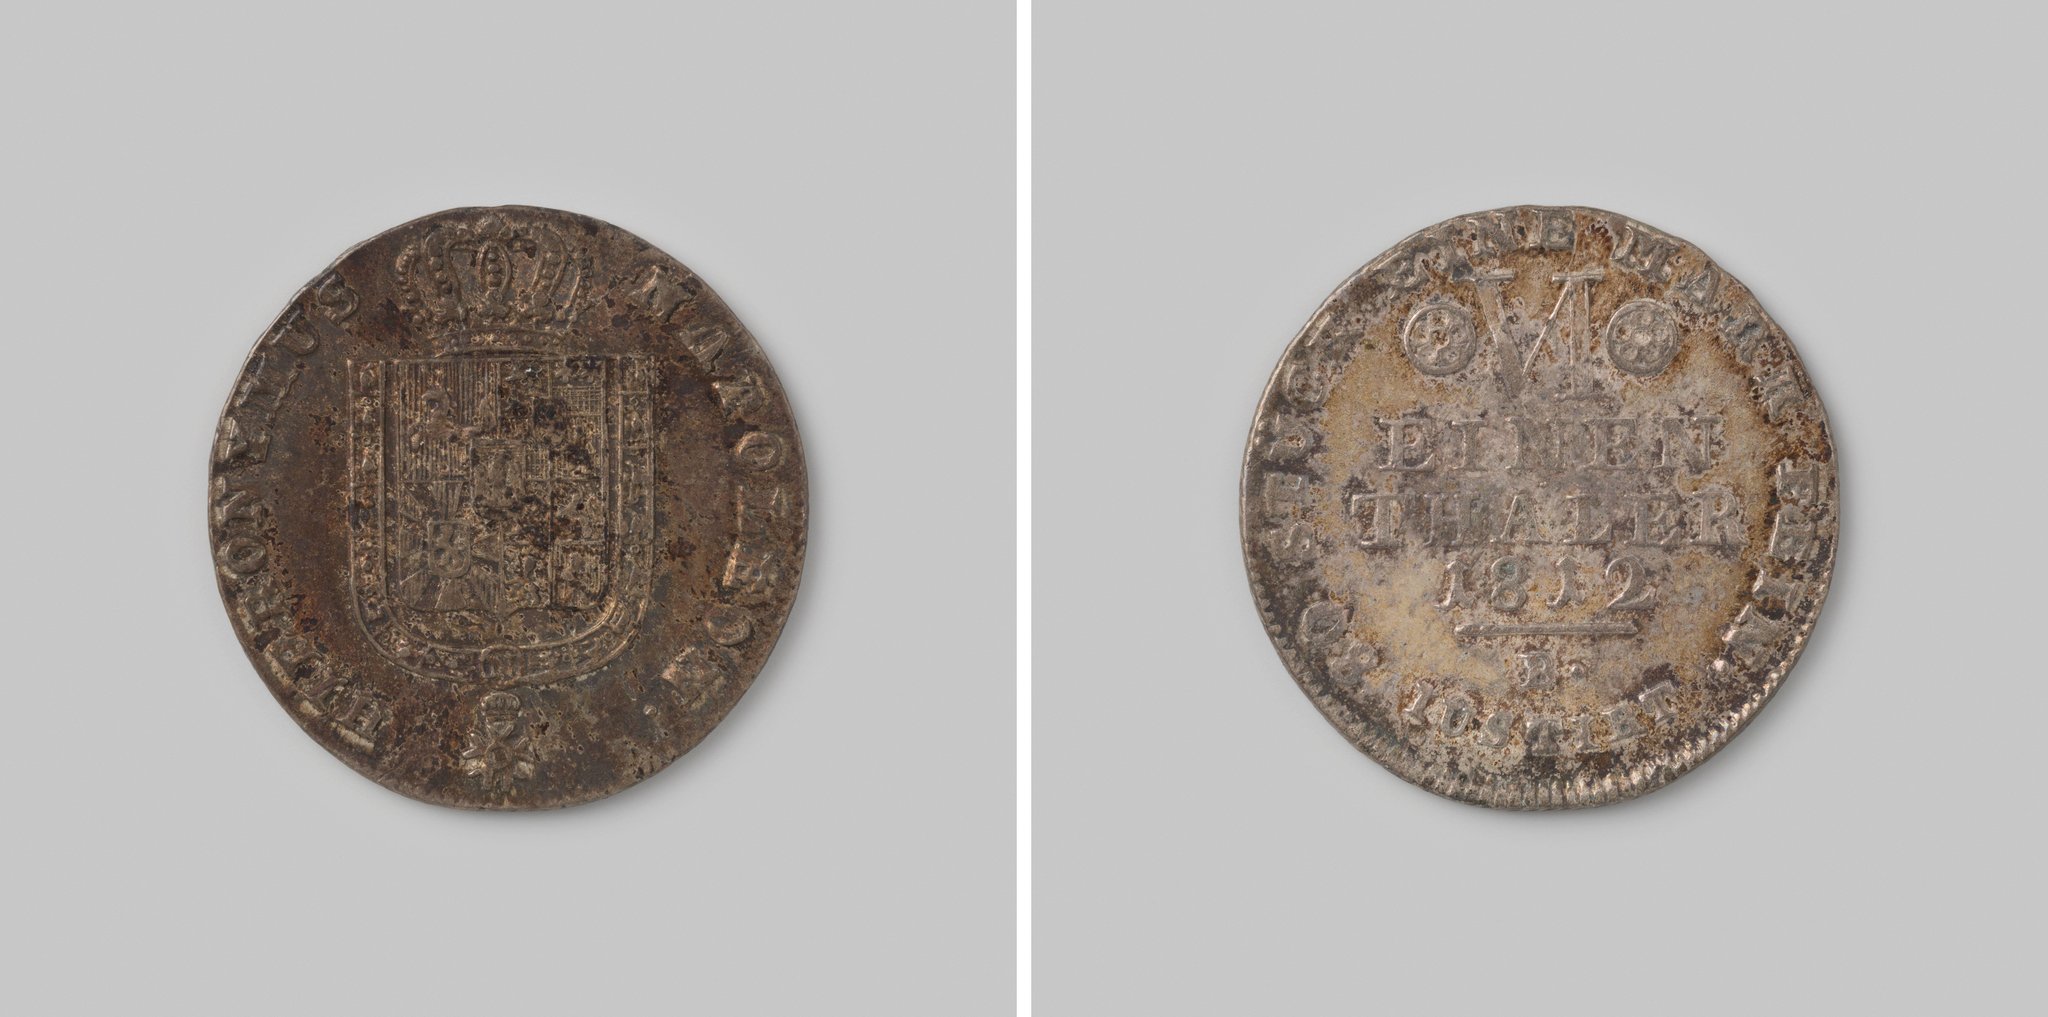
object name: zesde taler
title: Zesde taler uit het koninkrijk Westfalen van Jérome Napoléon, 1812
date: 1812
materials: silver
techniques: striking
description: Zilveren munt. Voorzijde: gekroond samengesteld wapenschild, omhangen met keten van orde, waaaan juweel. Keerzijde: waarde-aanduiding in drie regels, waaronder jaartal. Daaronder letter B [=Brunswick]. Kabelrand.